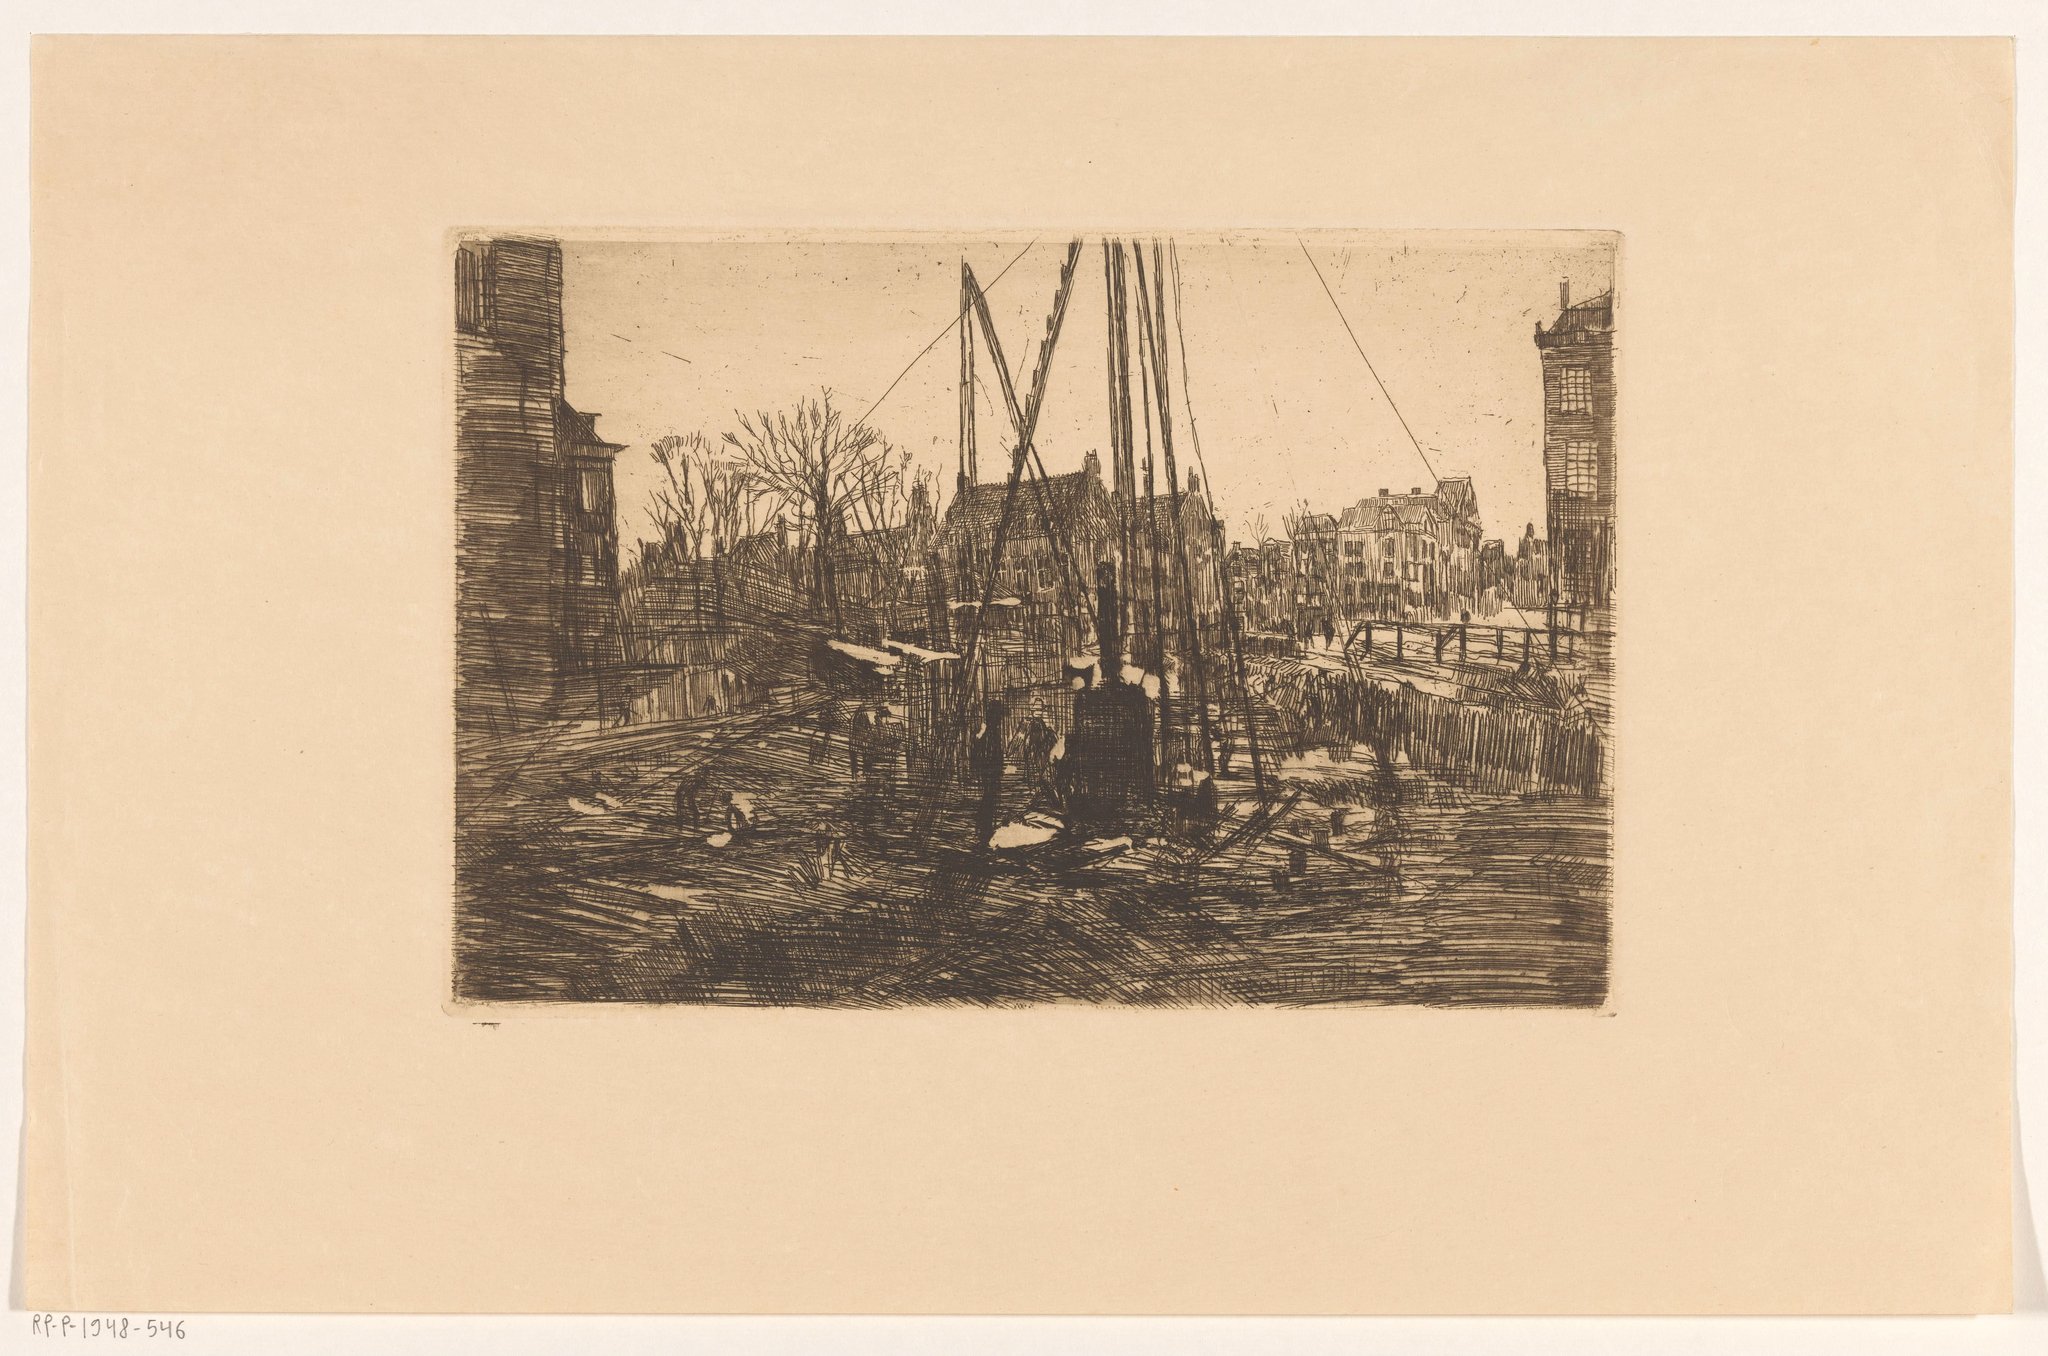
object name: print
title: Heiwerk in de Raadhuisstraat in Amsterdam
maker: george hendrik breitner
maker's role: draughtsman, painter, print maker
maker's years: 1857-1923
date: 1898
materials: paper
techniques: etching, intaglio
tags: city-view, and landscape with man-made constructions, building-site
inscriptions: collector's mark: Lugt 2228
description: De bouwput van de winkelgalerij in de Amsterdamse Raadhuisstraat.